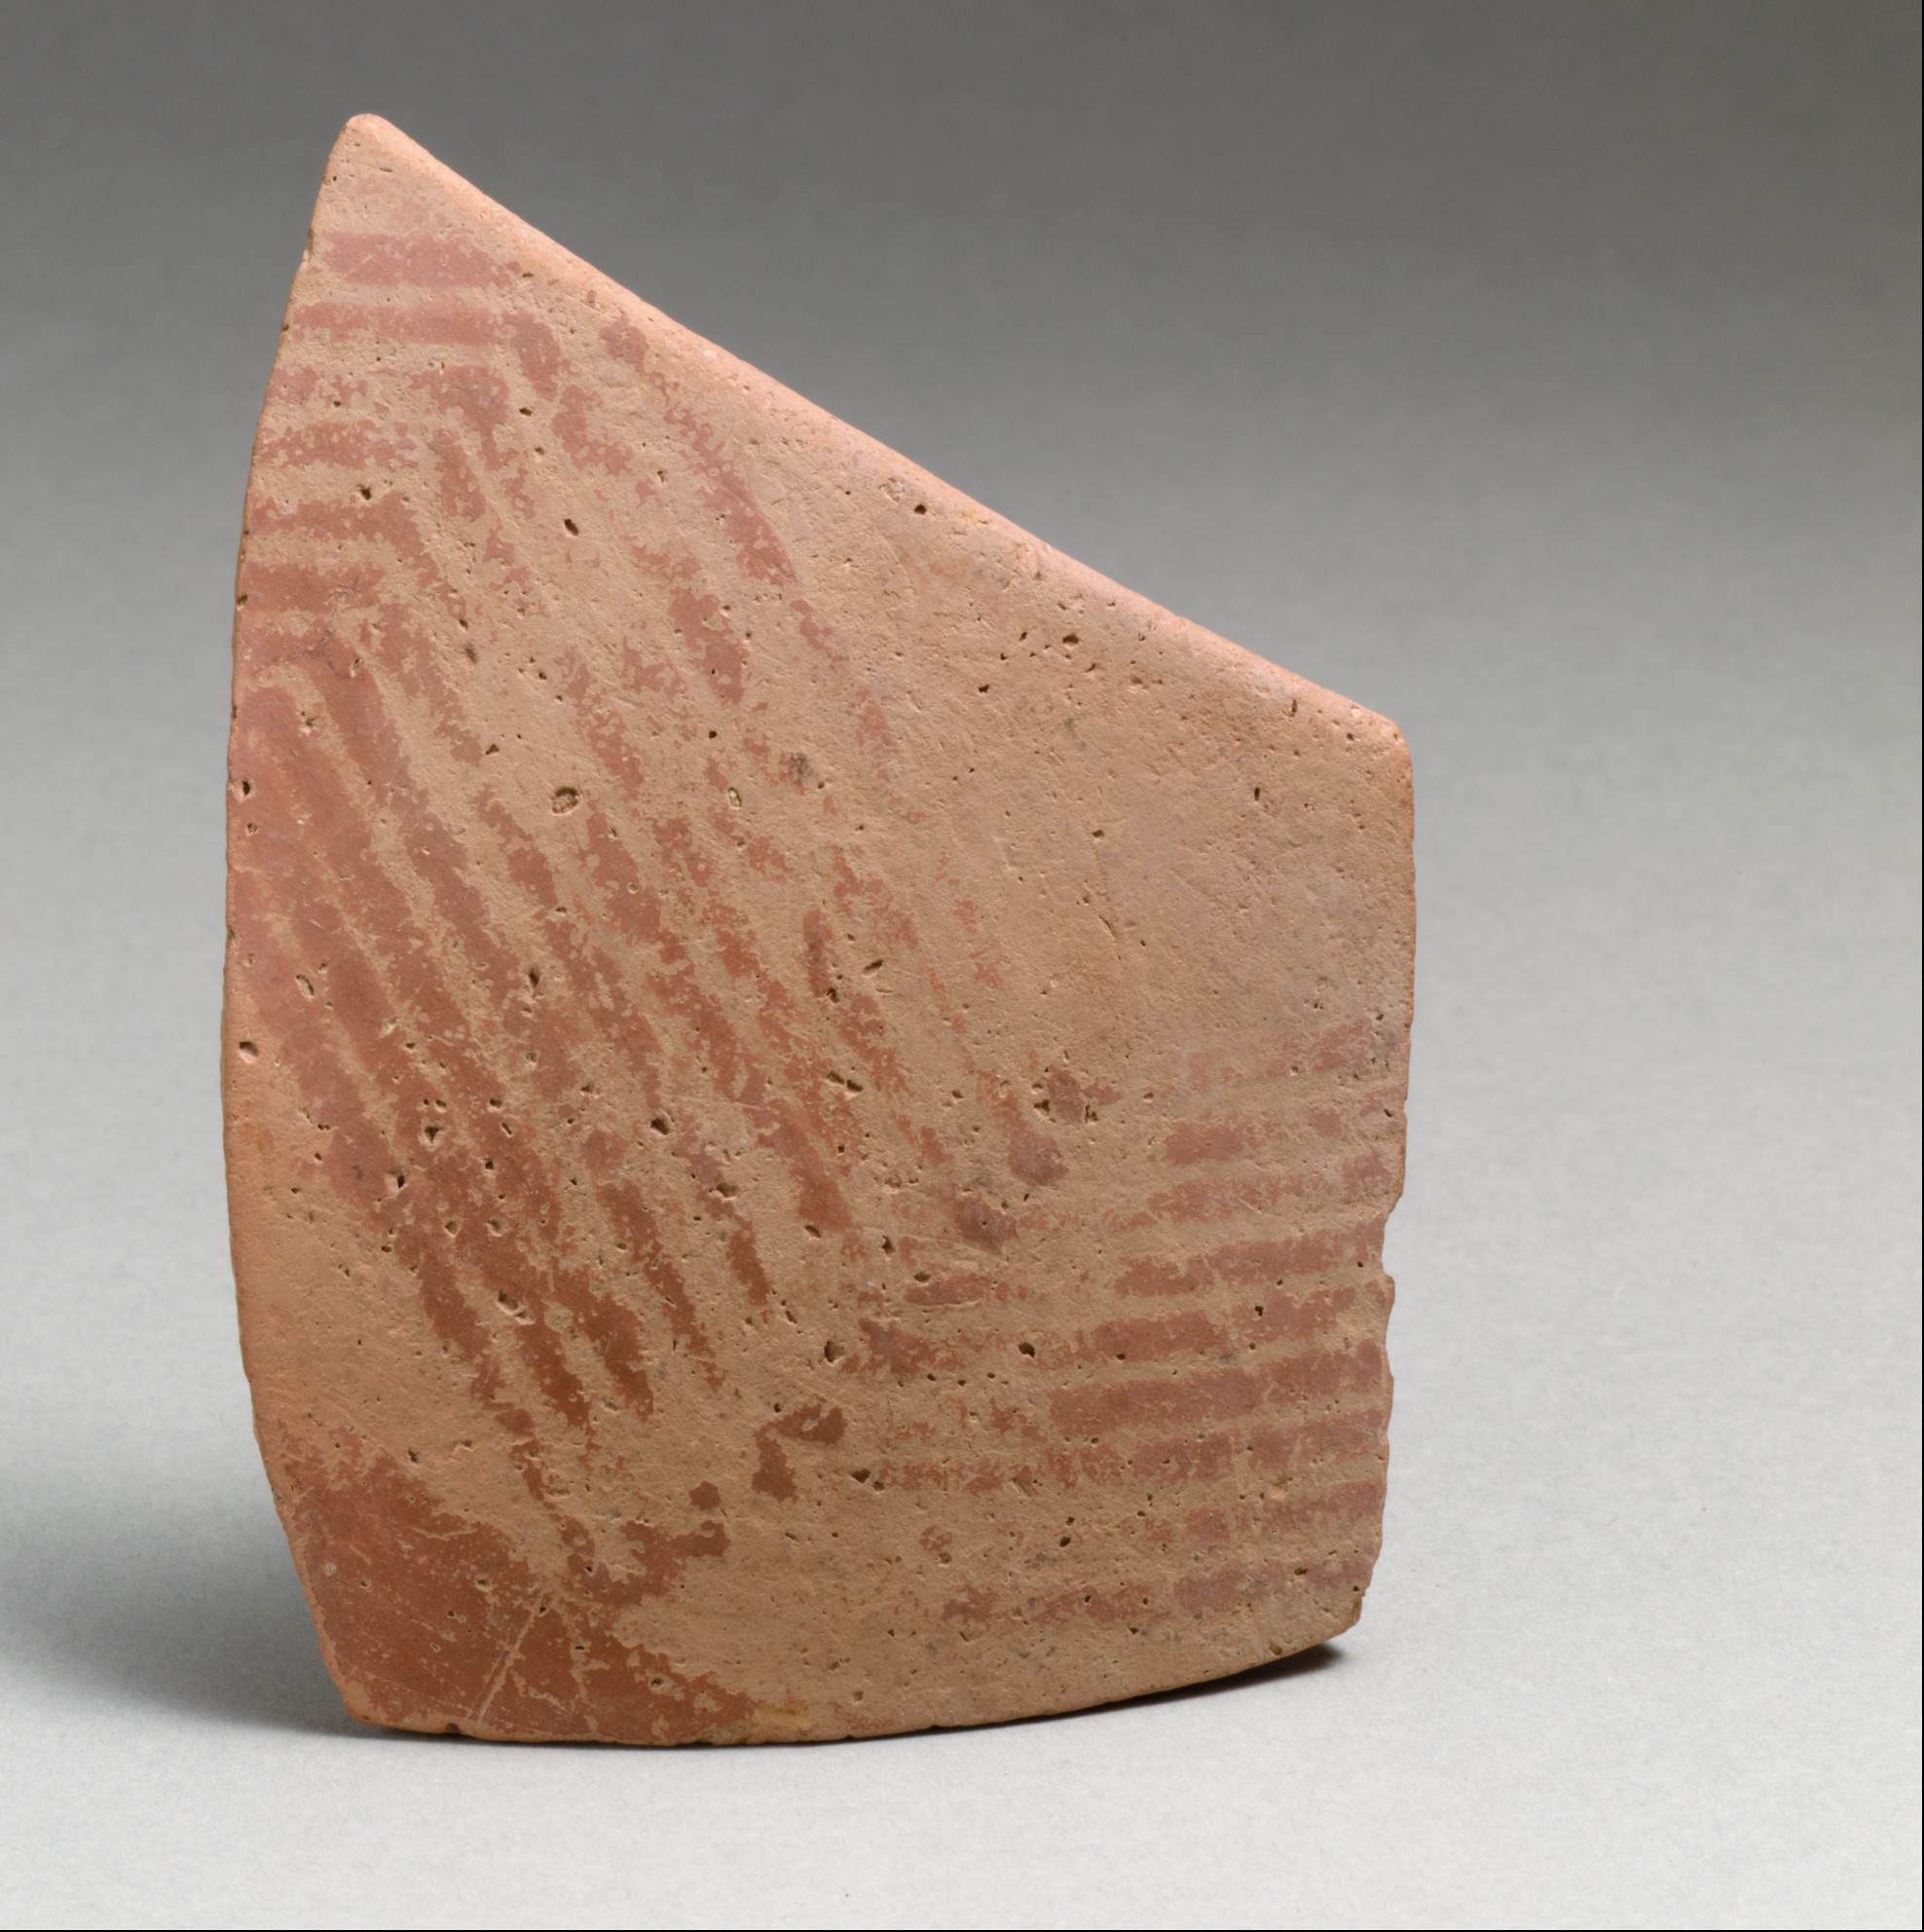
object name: vase fragment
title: Terracotta rim fragment with linear decoration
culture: greek neolithic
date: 4000 BCE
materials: terracotta